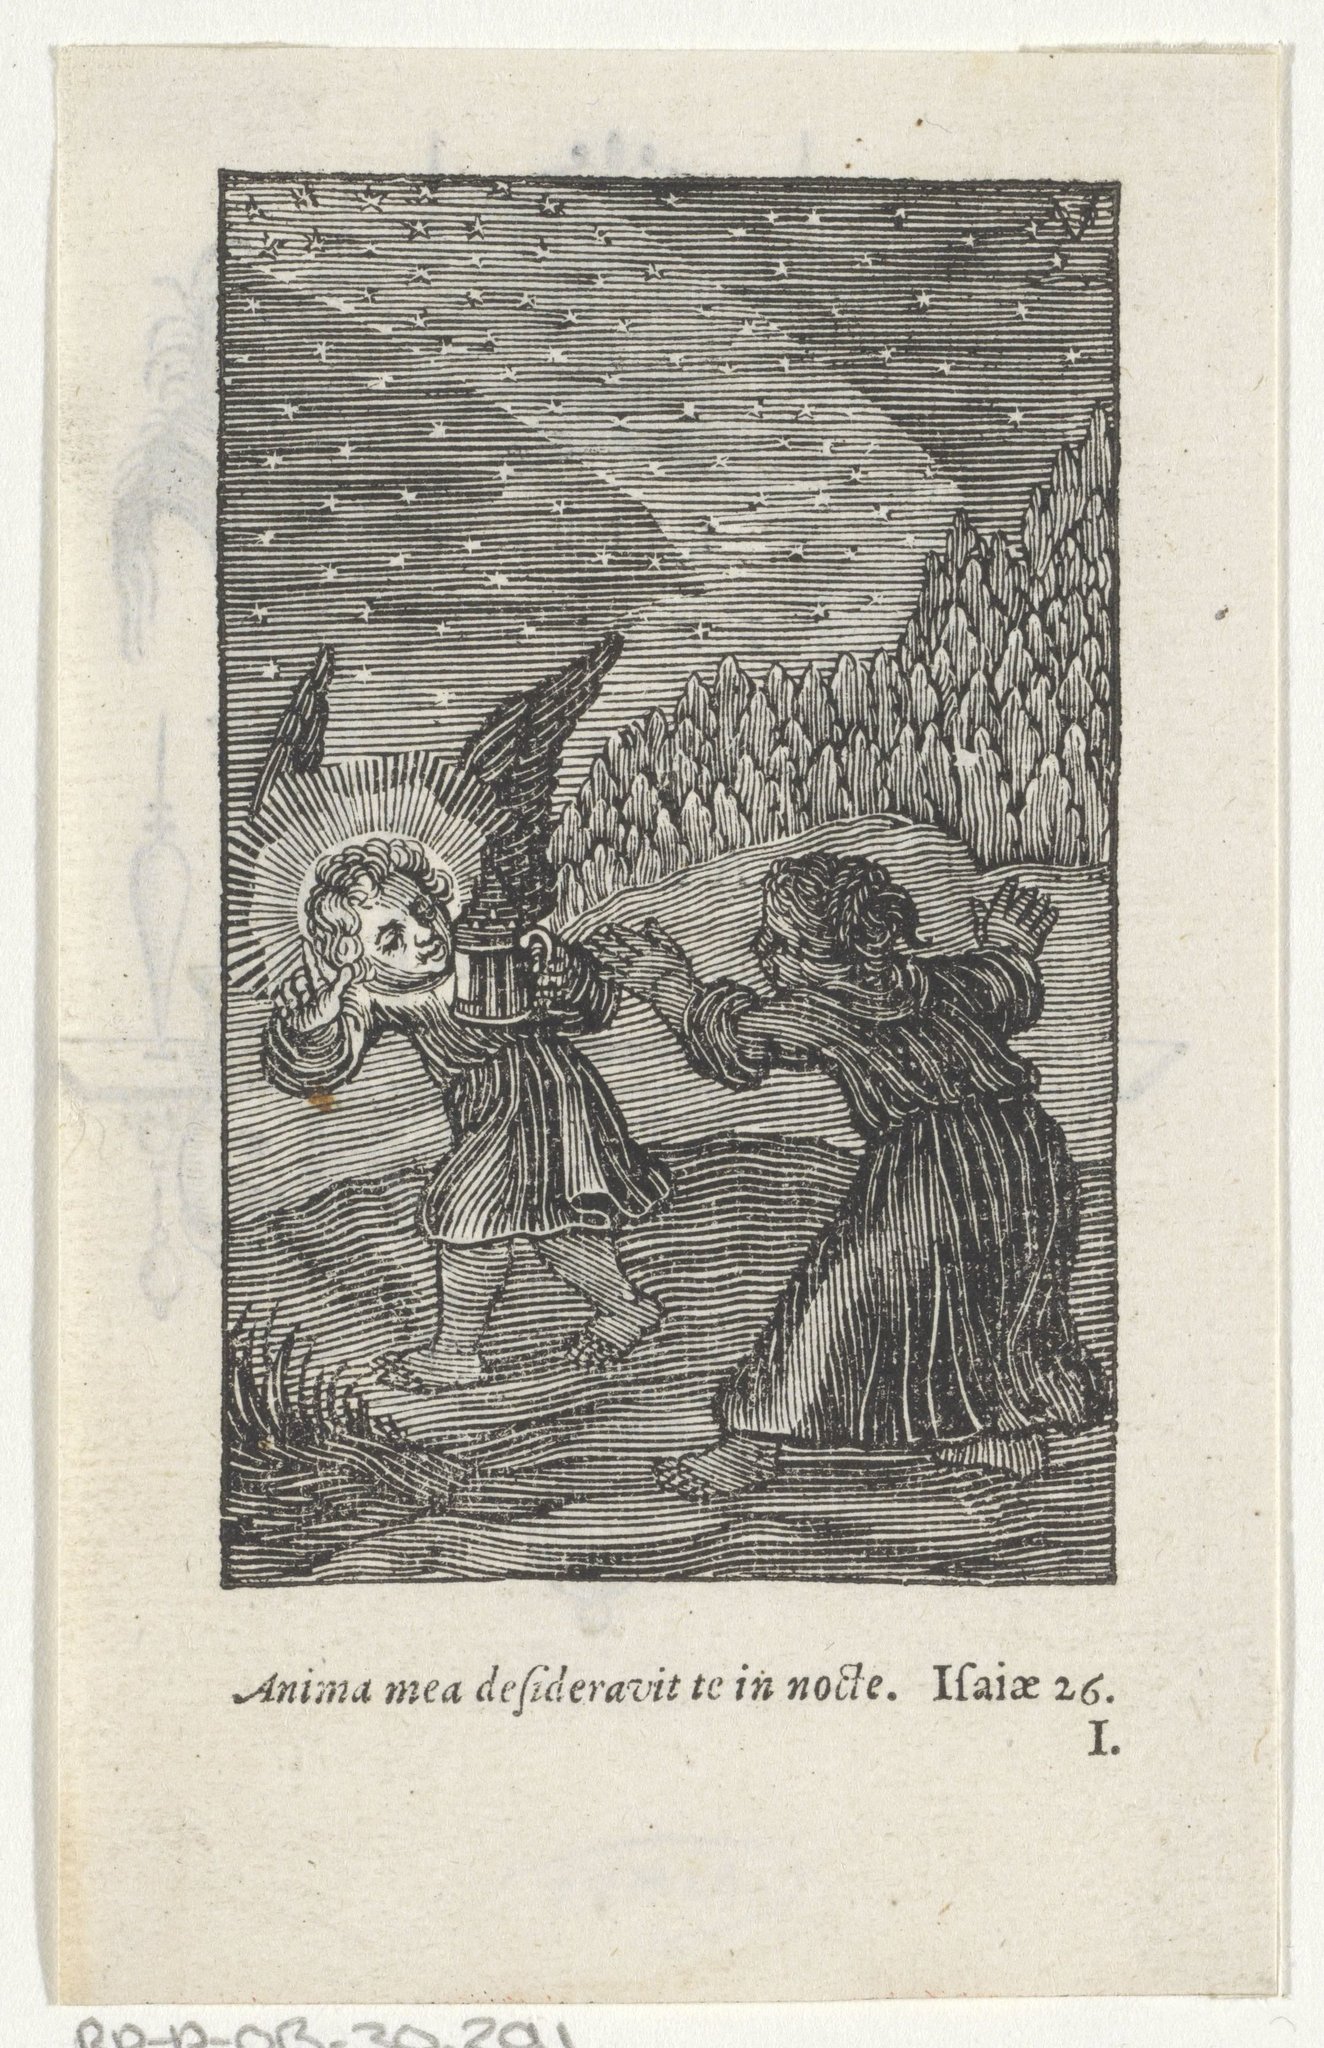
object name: book illustration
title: Anima mea desideravit te in nocte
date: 1628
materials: paper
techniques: letterpress printing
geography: amsterdam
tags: the book of isaiah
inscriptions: collector's mark: Lugt 2228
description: Prent uit: Hugo, Herman. Pia desideria. Antwerpen: Hendrick Aertssens, 1628.